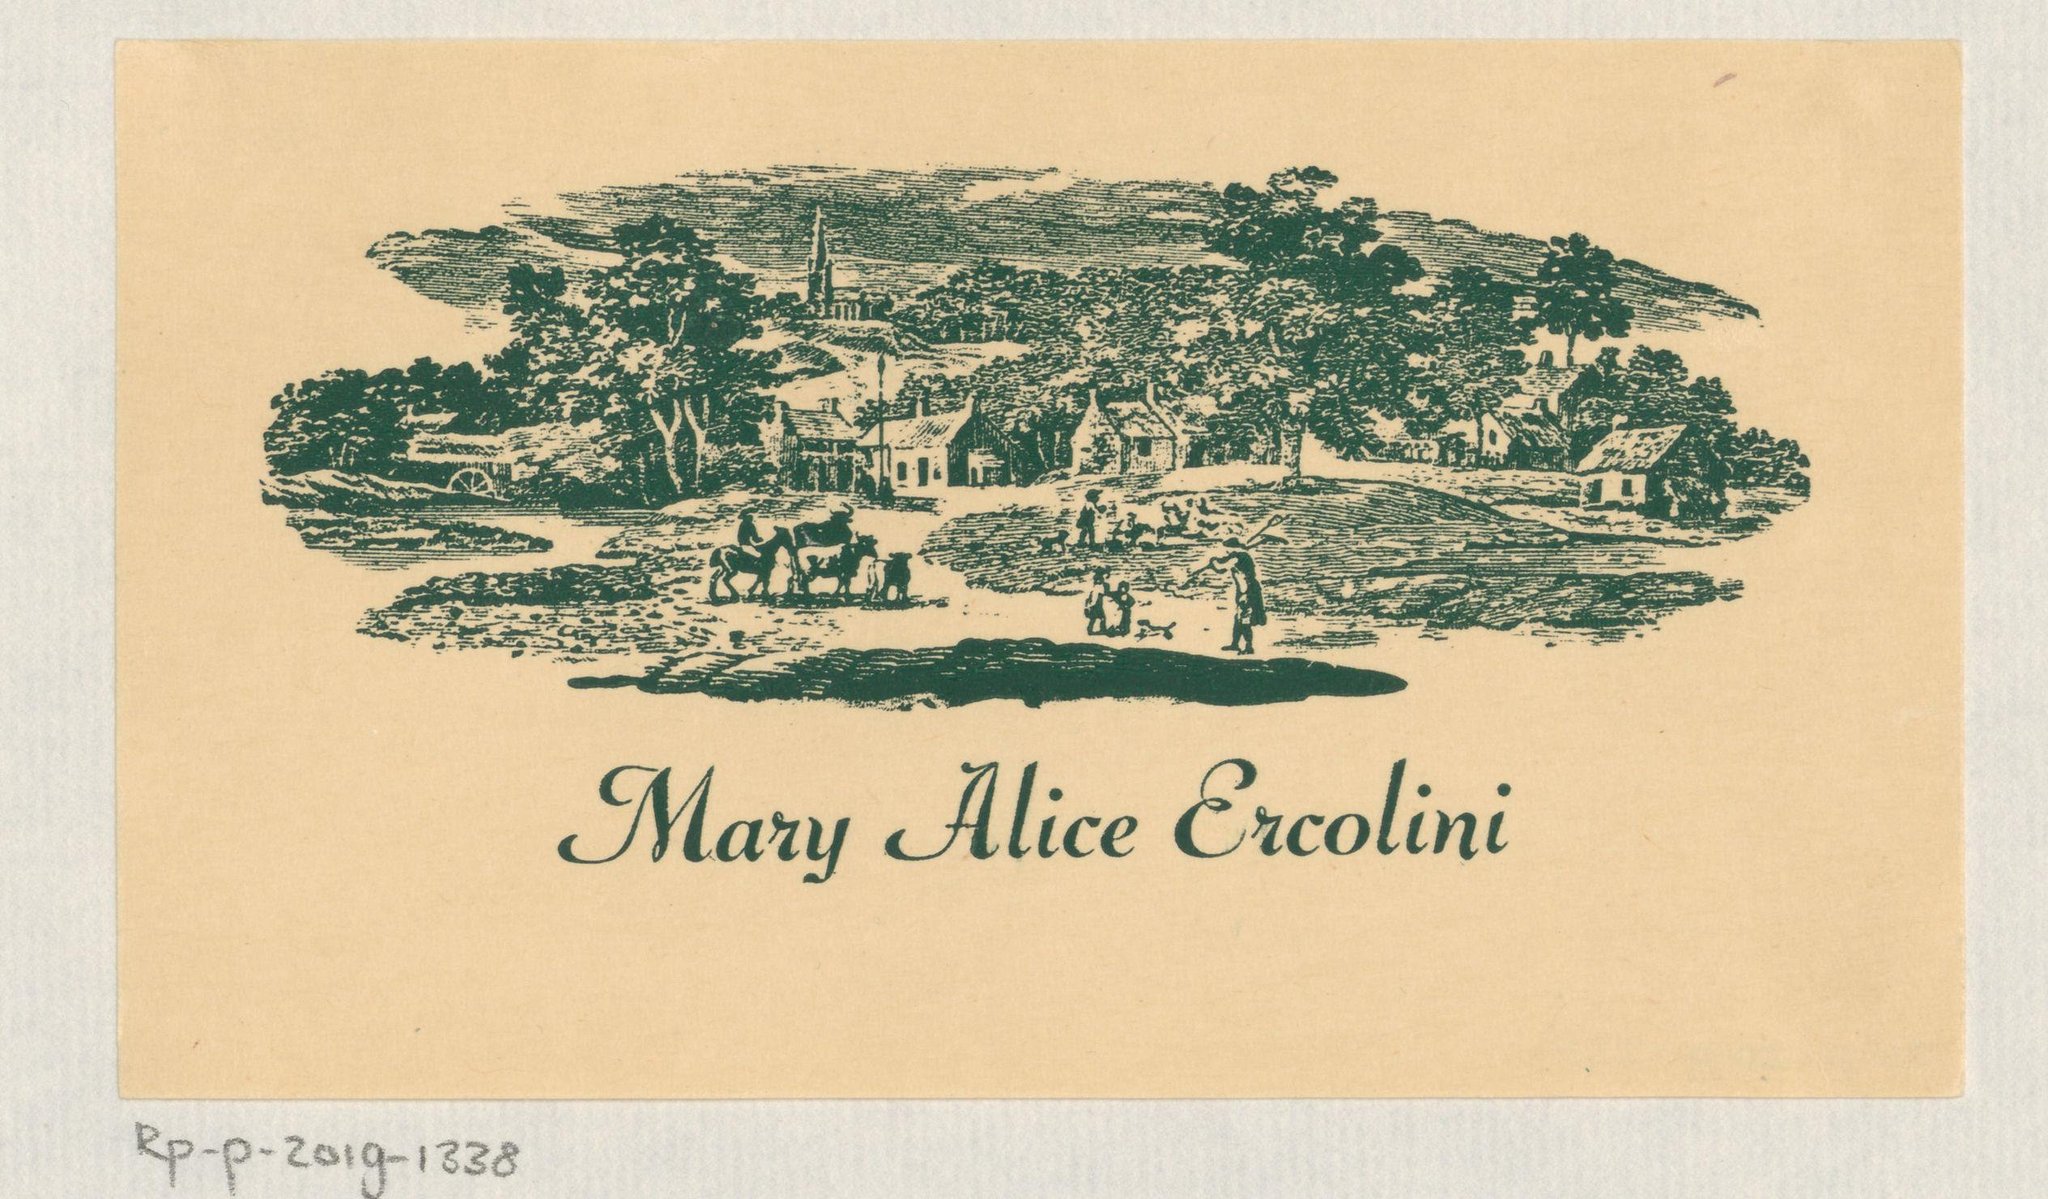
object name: bookplate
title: Ex libris van Mary Alice Ercolini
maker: thomas bewick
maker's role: draughtsman, painter, print maker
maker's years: 1753-1828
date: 1790-1828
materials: paper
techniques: engraving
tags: mary alice ercolini, prospect of village, silhouette of village